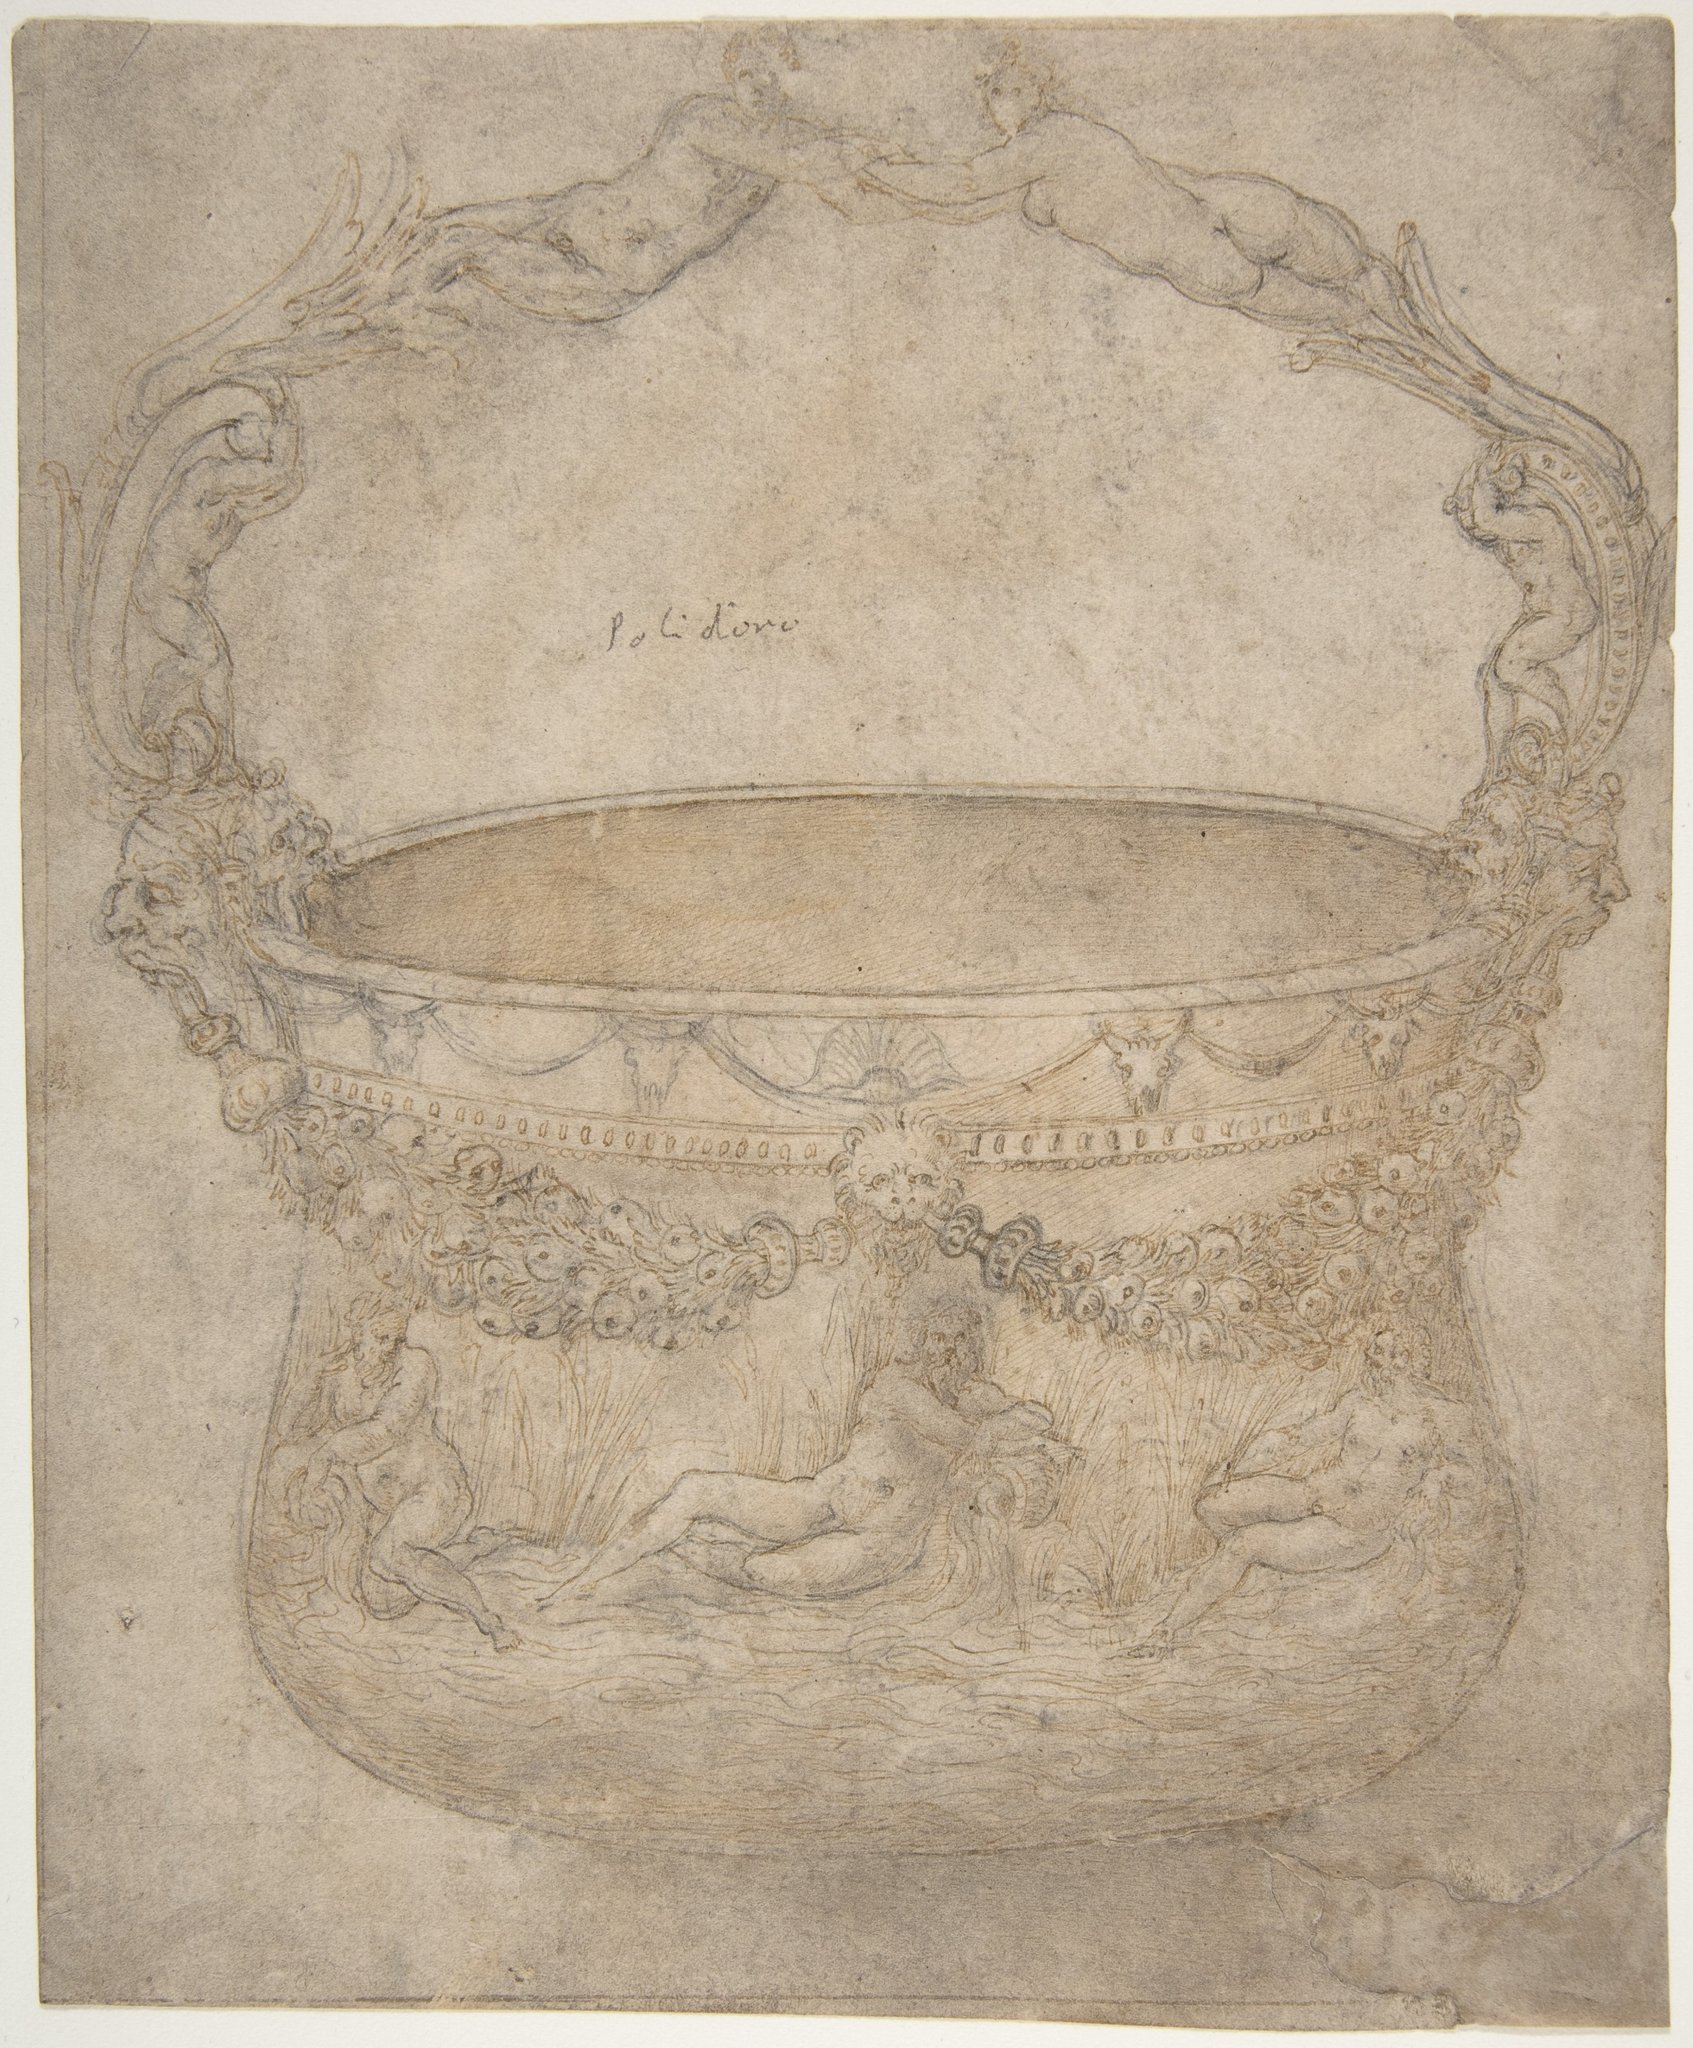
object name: drawing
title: Design for a Bucket-Like Vessel with a Handle of Interlaced Figures, on a Body Adorned with Bucrania, Garlands, and Three River Gods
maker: girolamo genga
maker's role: artist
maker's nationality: italian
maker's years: 1467-1551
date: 1540-1550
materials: chalk, ink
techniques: brush, pen, wash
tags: garlands,male nudes,female nudes